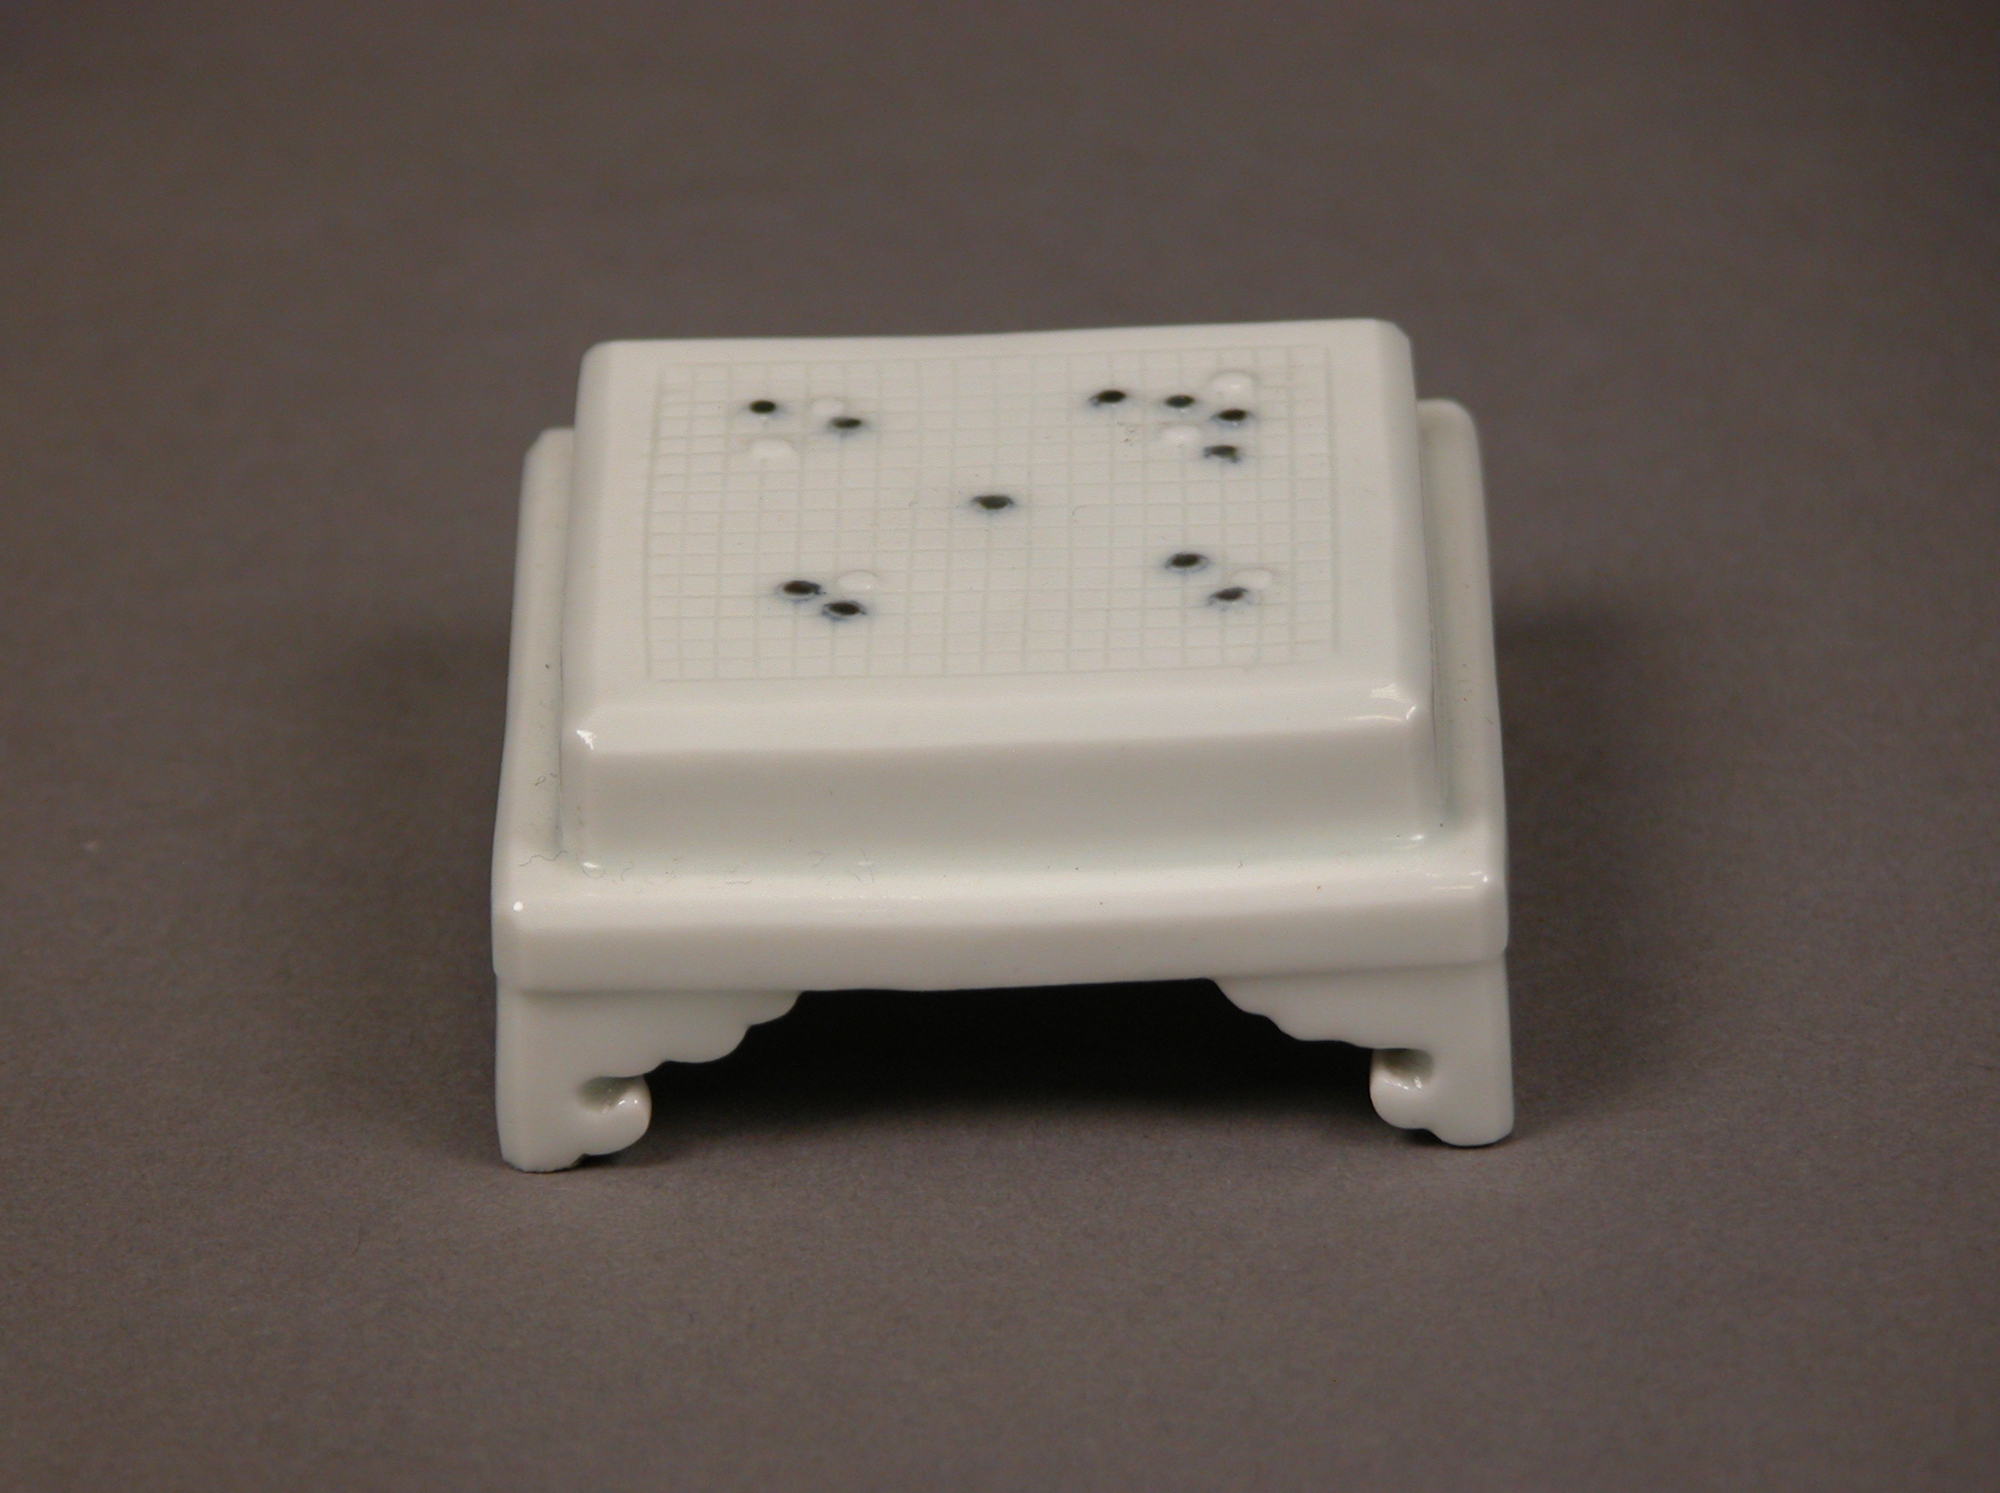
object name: miniature game stand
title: Miniature Stand for Game of Go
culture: japanese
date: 1767-1800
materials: porcelain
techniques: underglaze